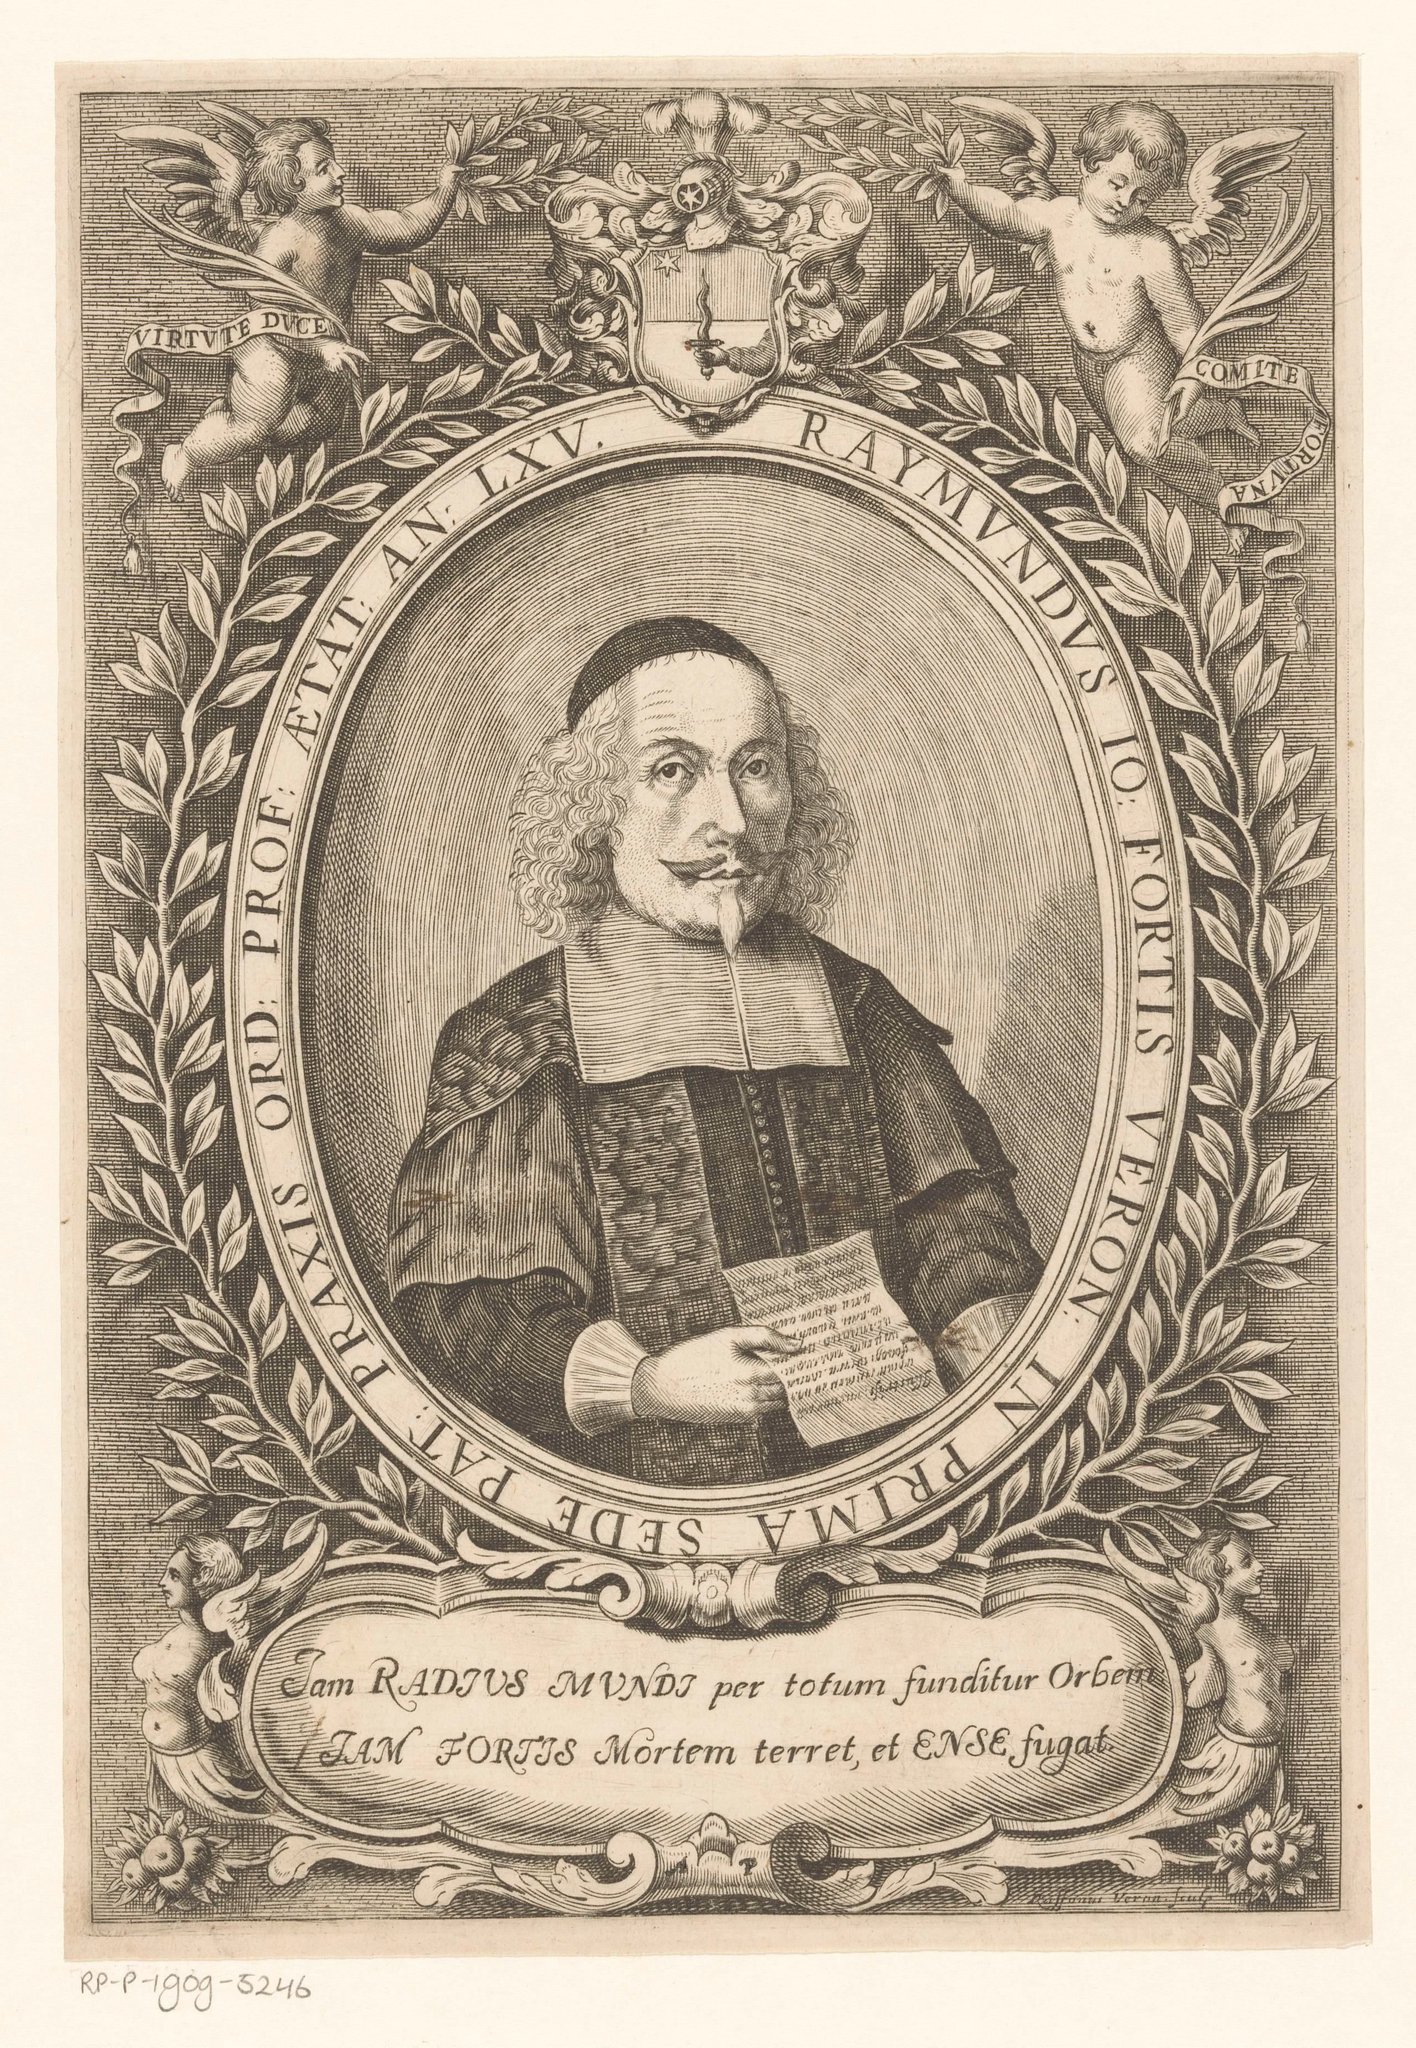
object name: print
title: Portret van professor Raymundus Ioannis Fortis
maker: raffanus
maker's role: print maker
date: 1600-1699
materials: paper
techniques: engraving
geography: verona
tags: historical persons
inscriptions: collector's mark: Lugt 2228